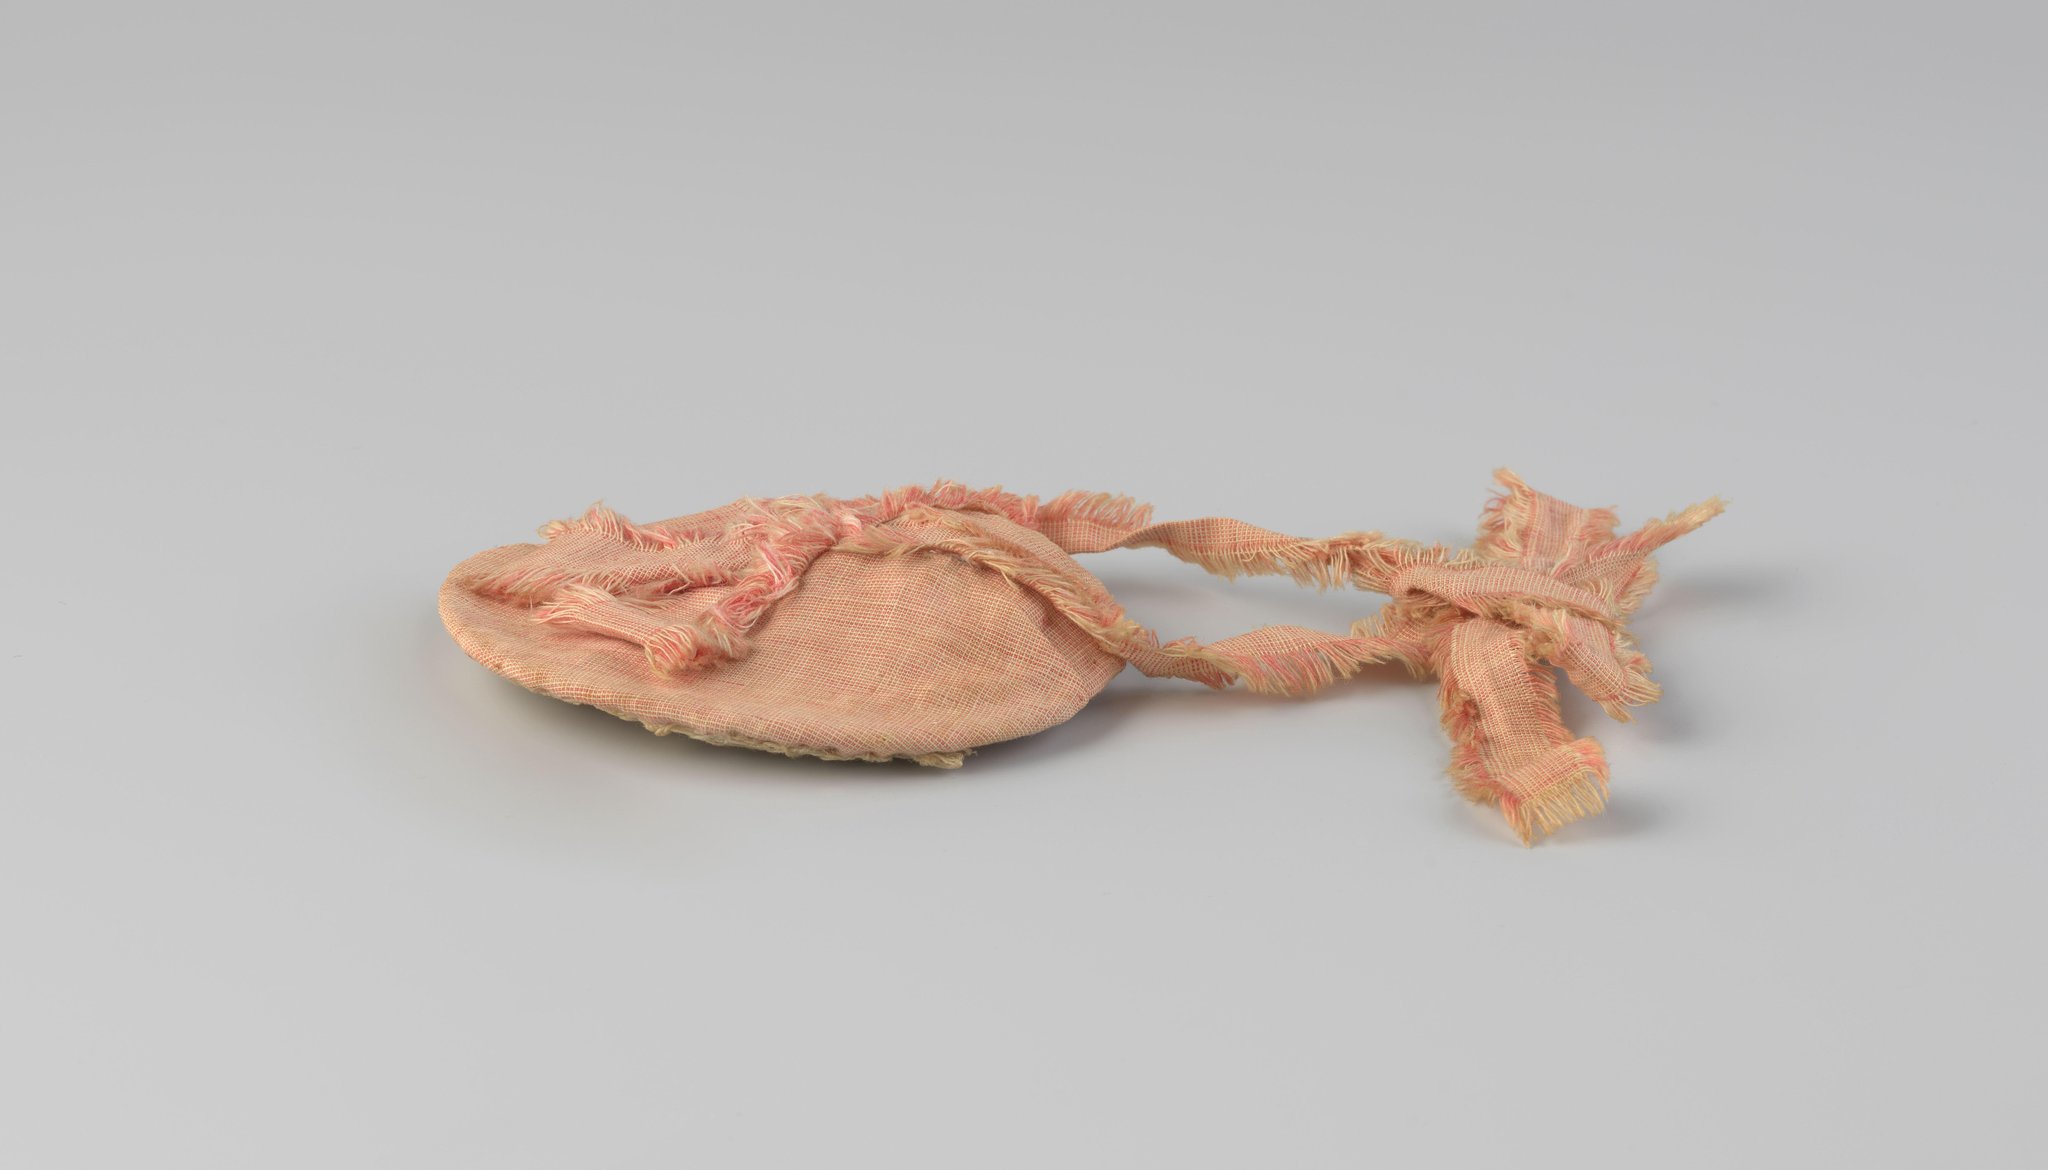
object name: doll's clothing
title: Hoed, plat model met strik en linten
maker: Anonymous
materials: cotton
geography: netherlands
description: Plat hoedje van stro, van boven rood en wit katoen waarop een strik die in twee keelbanden overgaat, onderzijde met kant.